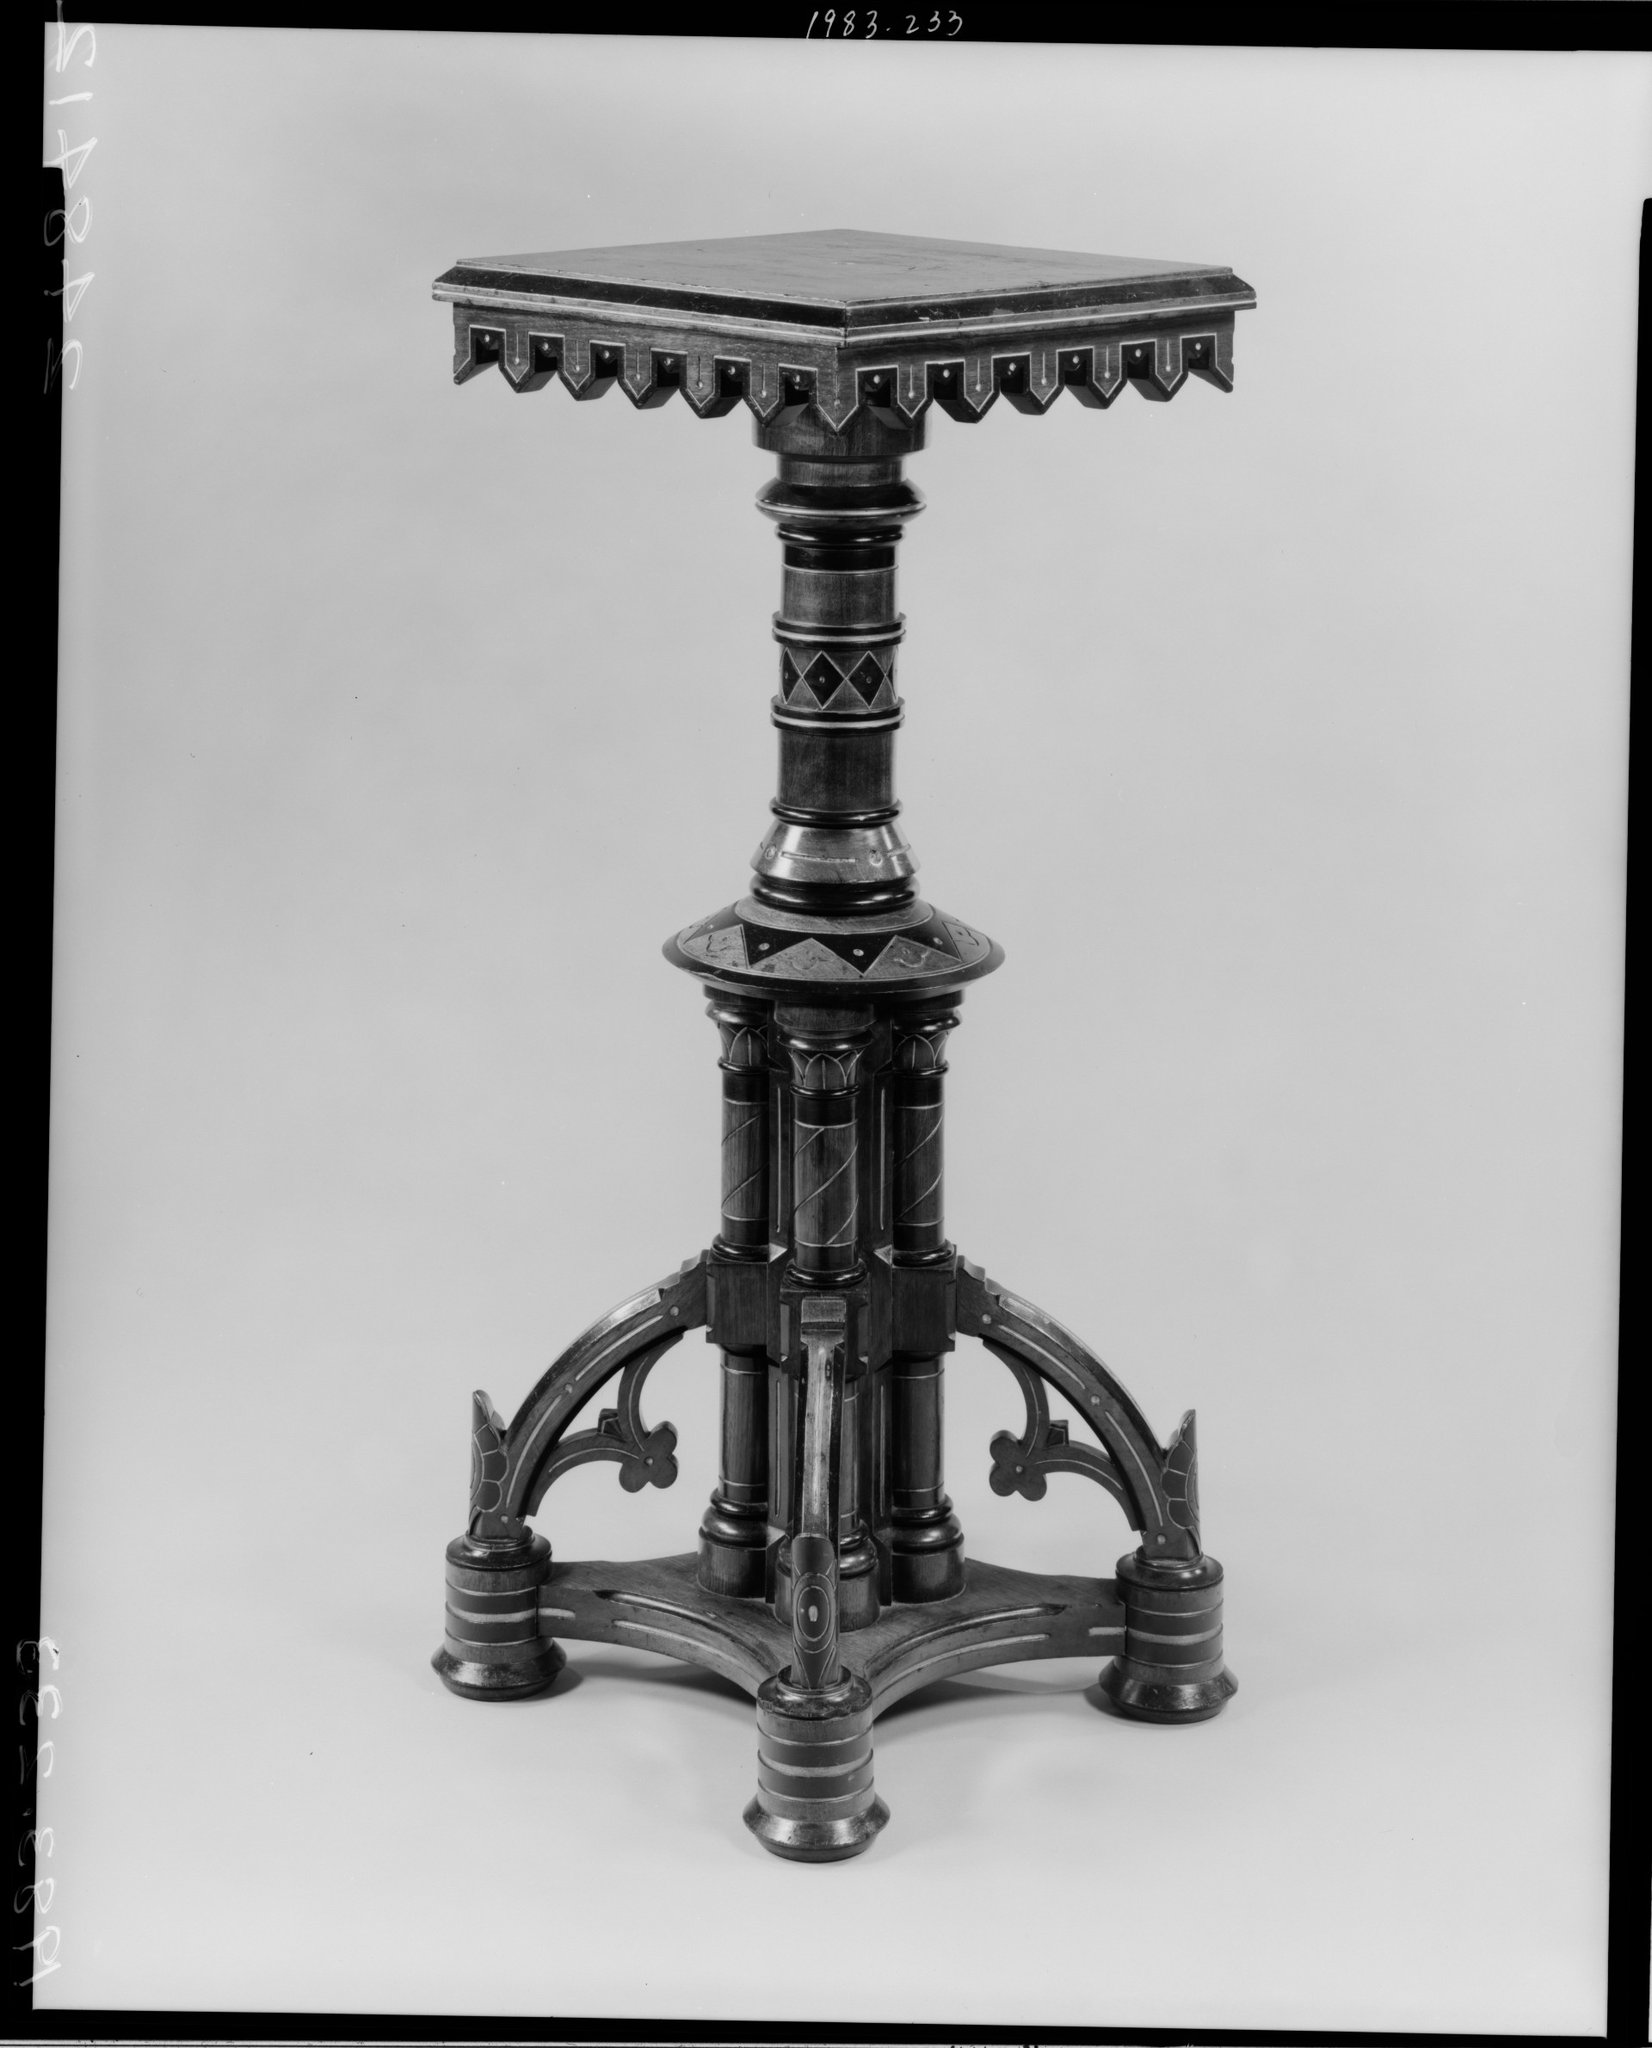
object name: pedestal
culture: american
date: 1875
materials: wood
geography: united states